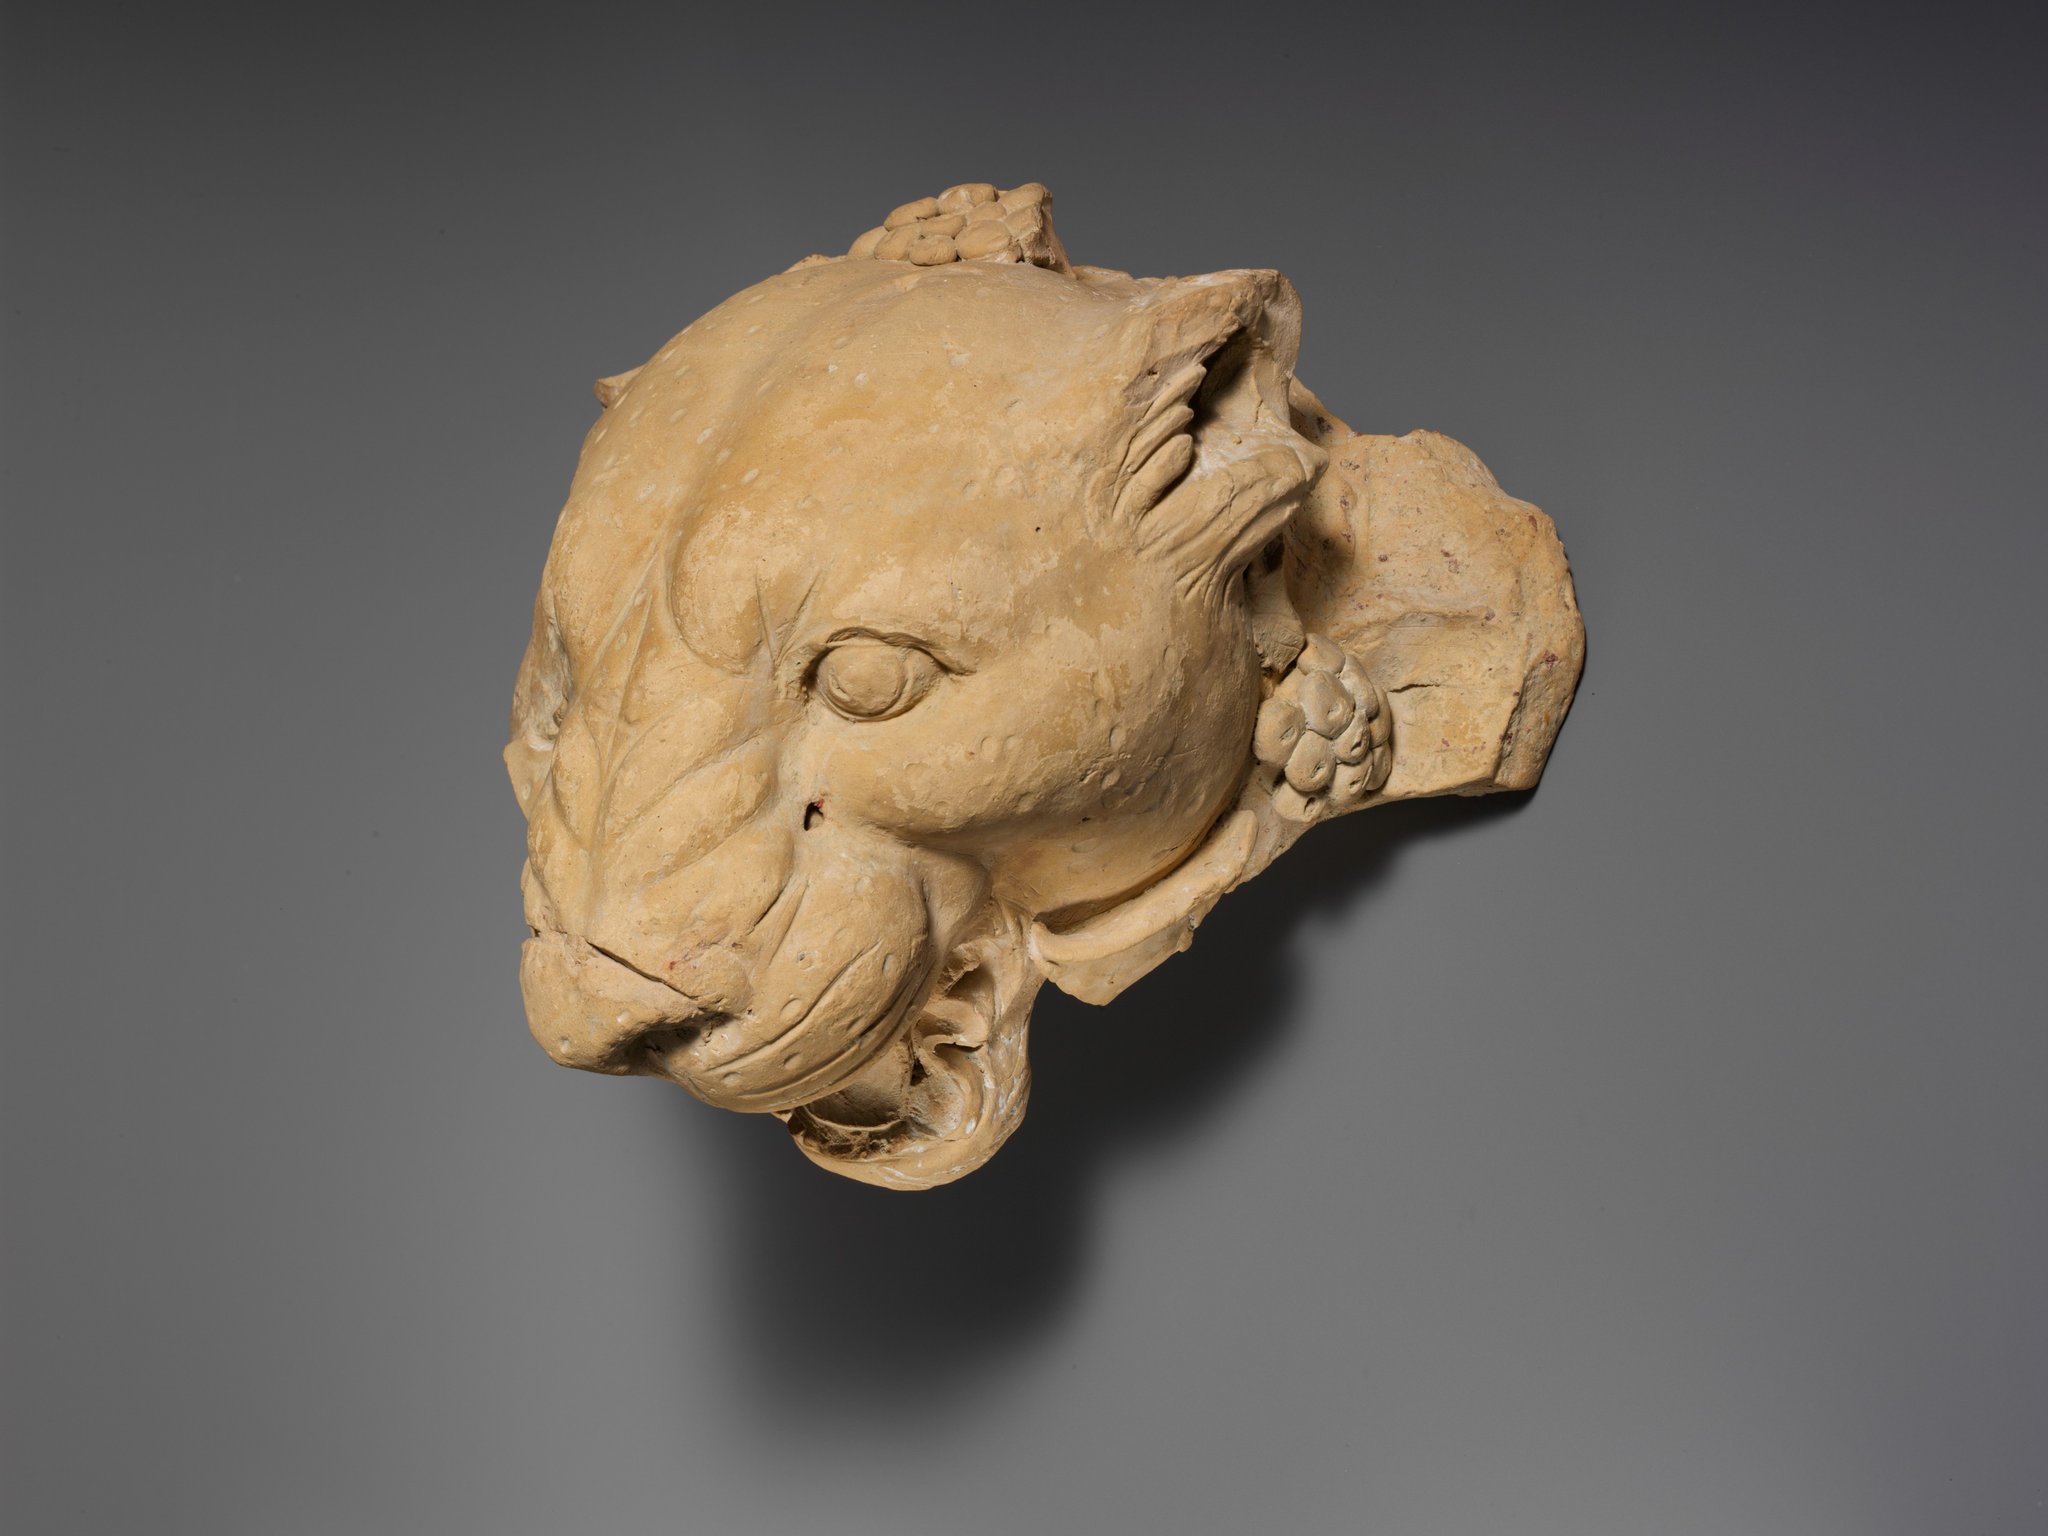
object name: head of a panther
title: Terracotta head of a panther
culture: roman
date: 1-100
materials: terracotta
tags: animals